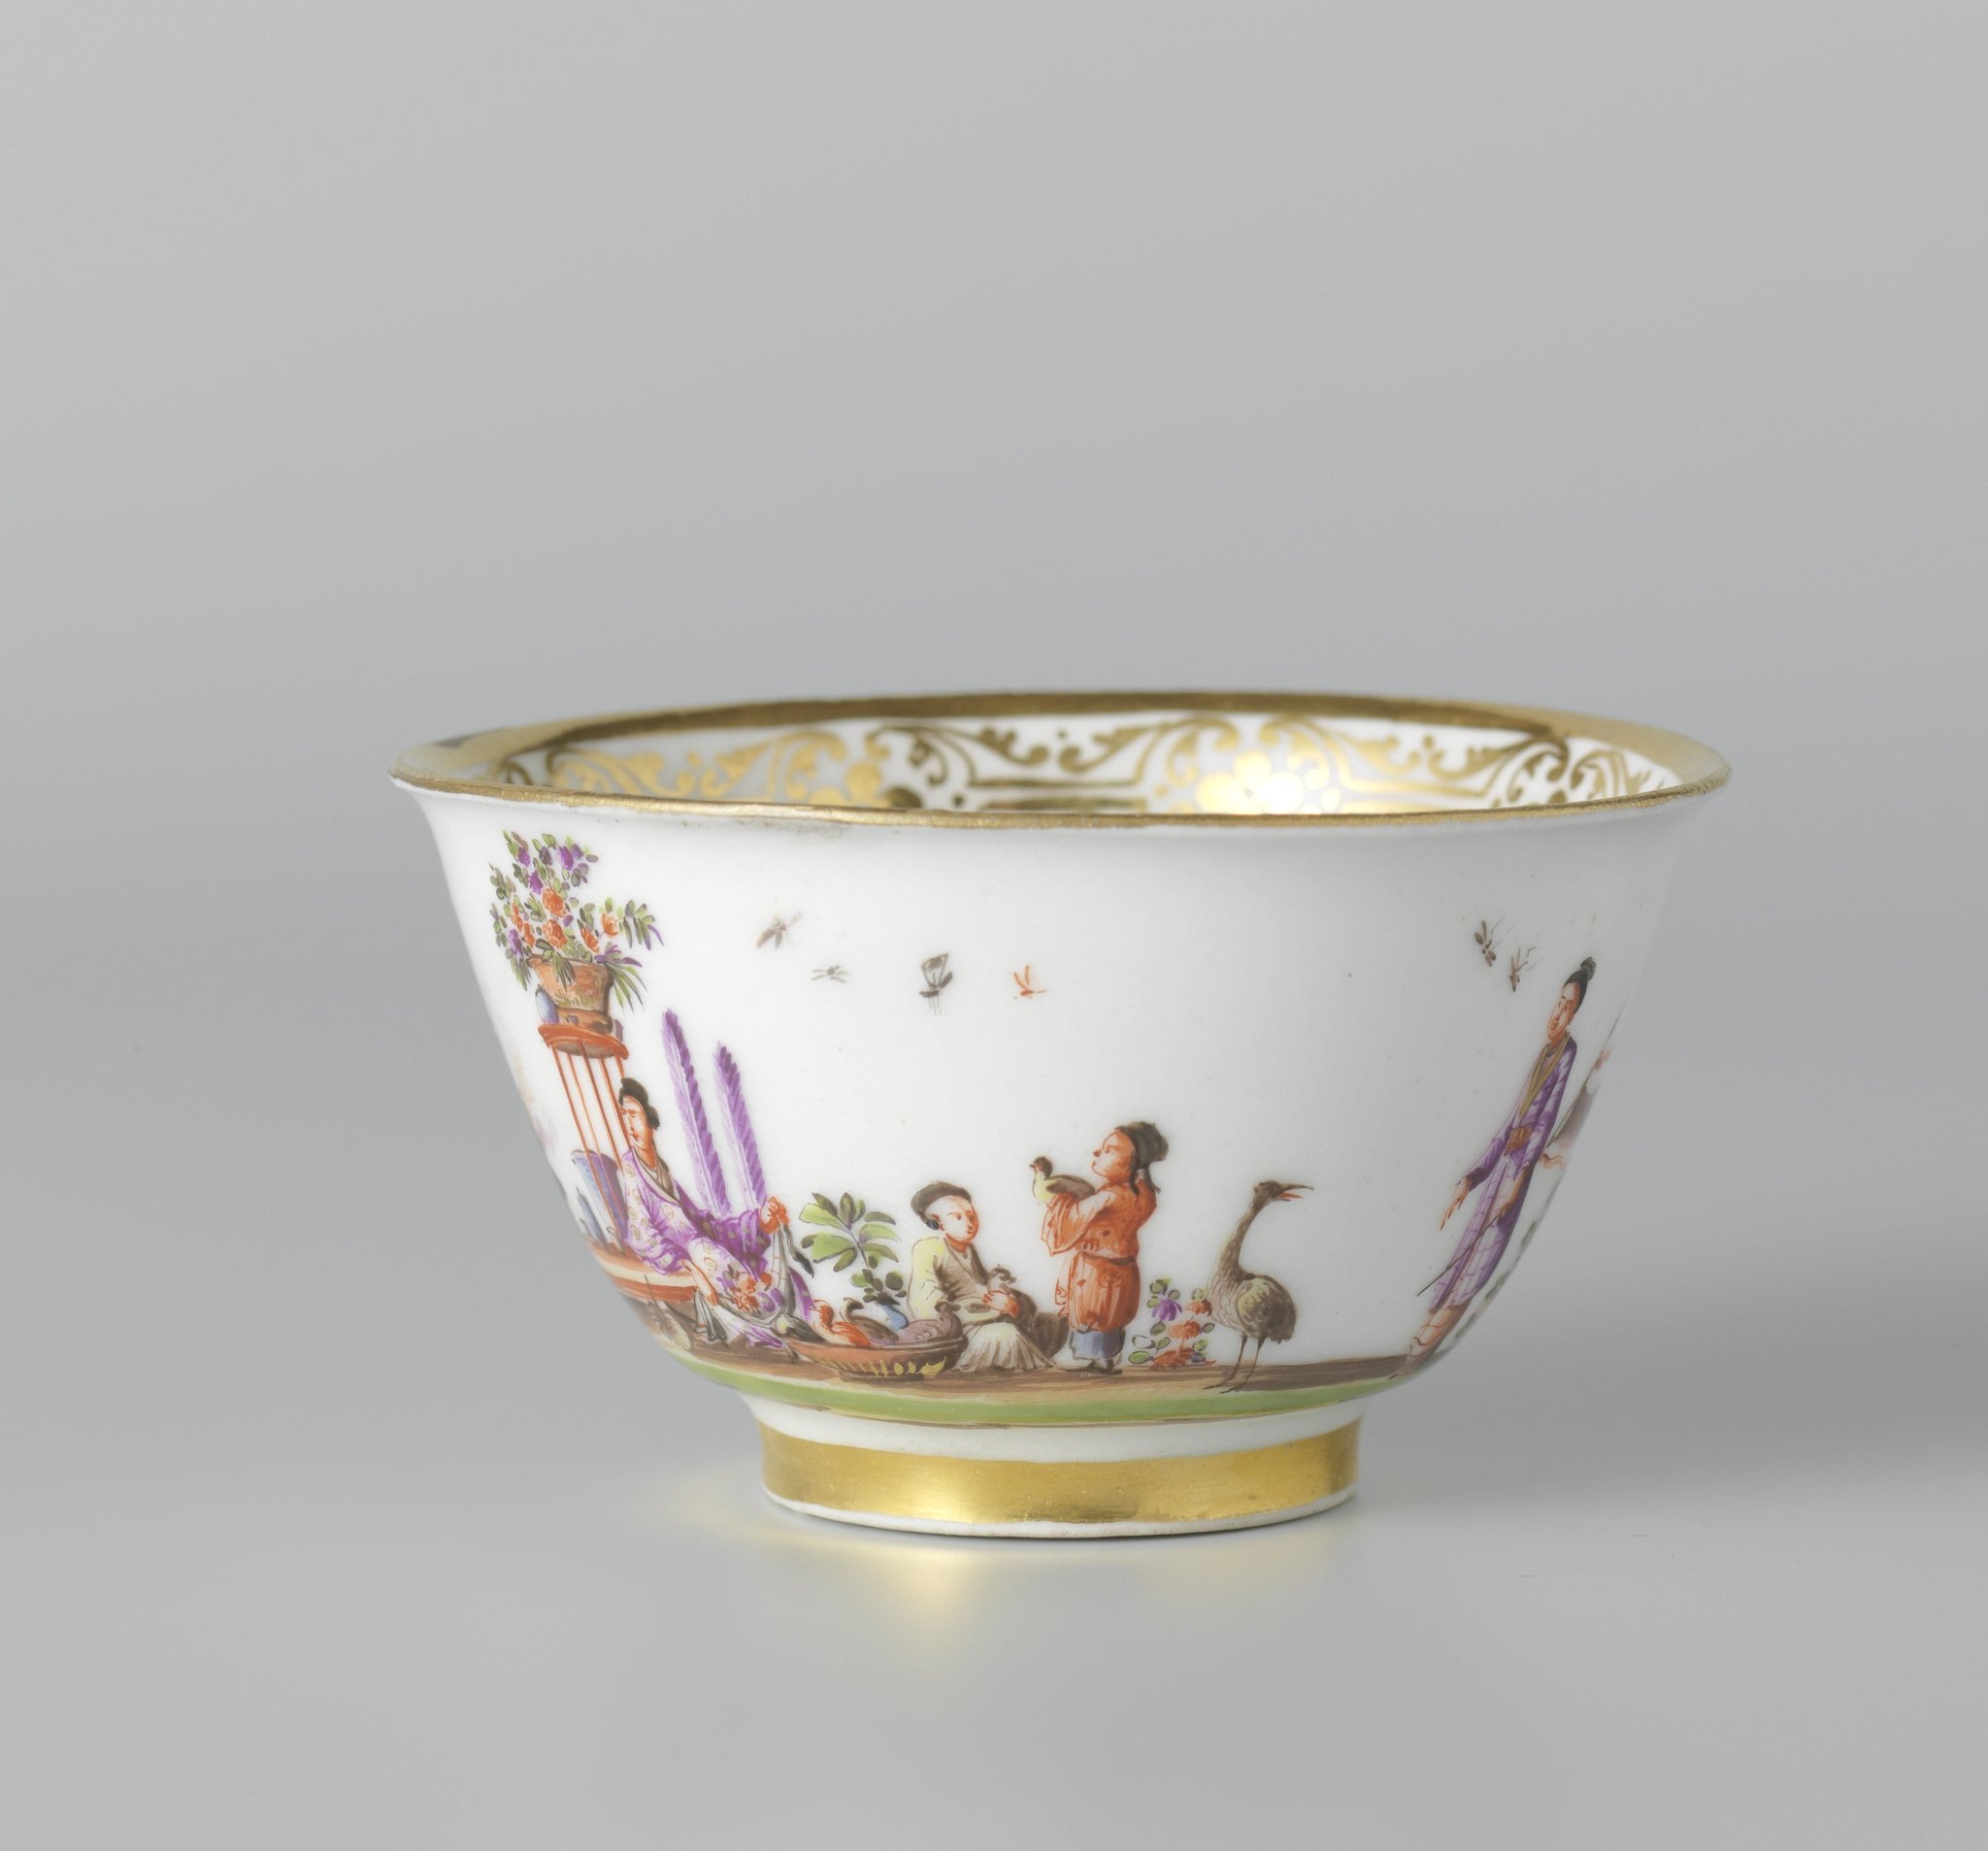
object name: cup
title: Kop, veelkleurig beschilderd met chinoiserieën en het wapen van de Venetiaanse familie Morosini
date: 1731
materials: porcelain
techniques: painted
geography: meissen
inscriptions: factory mark, mark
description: Tea and coffee service with the arms of the Venetian ducal family Morosini. Porcelain in leather travelling case. Meissen, 1731, decorated in the style of Johann Gregorius Höroldt.